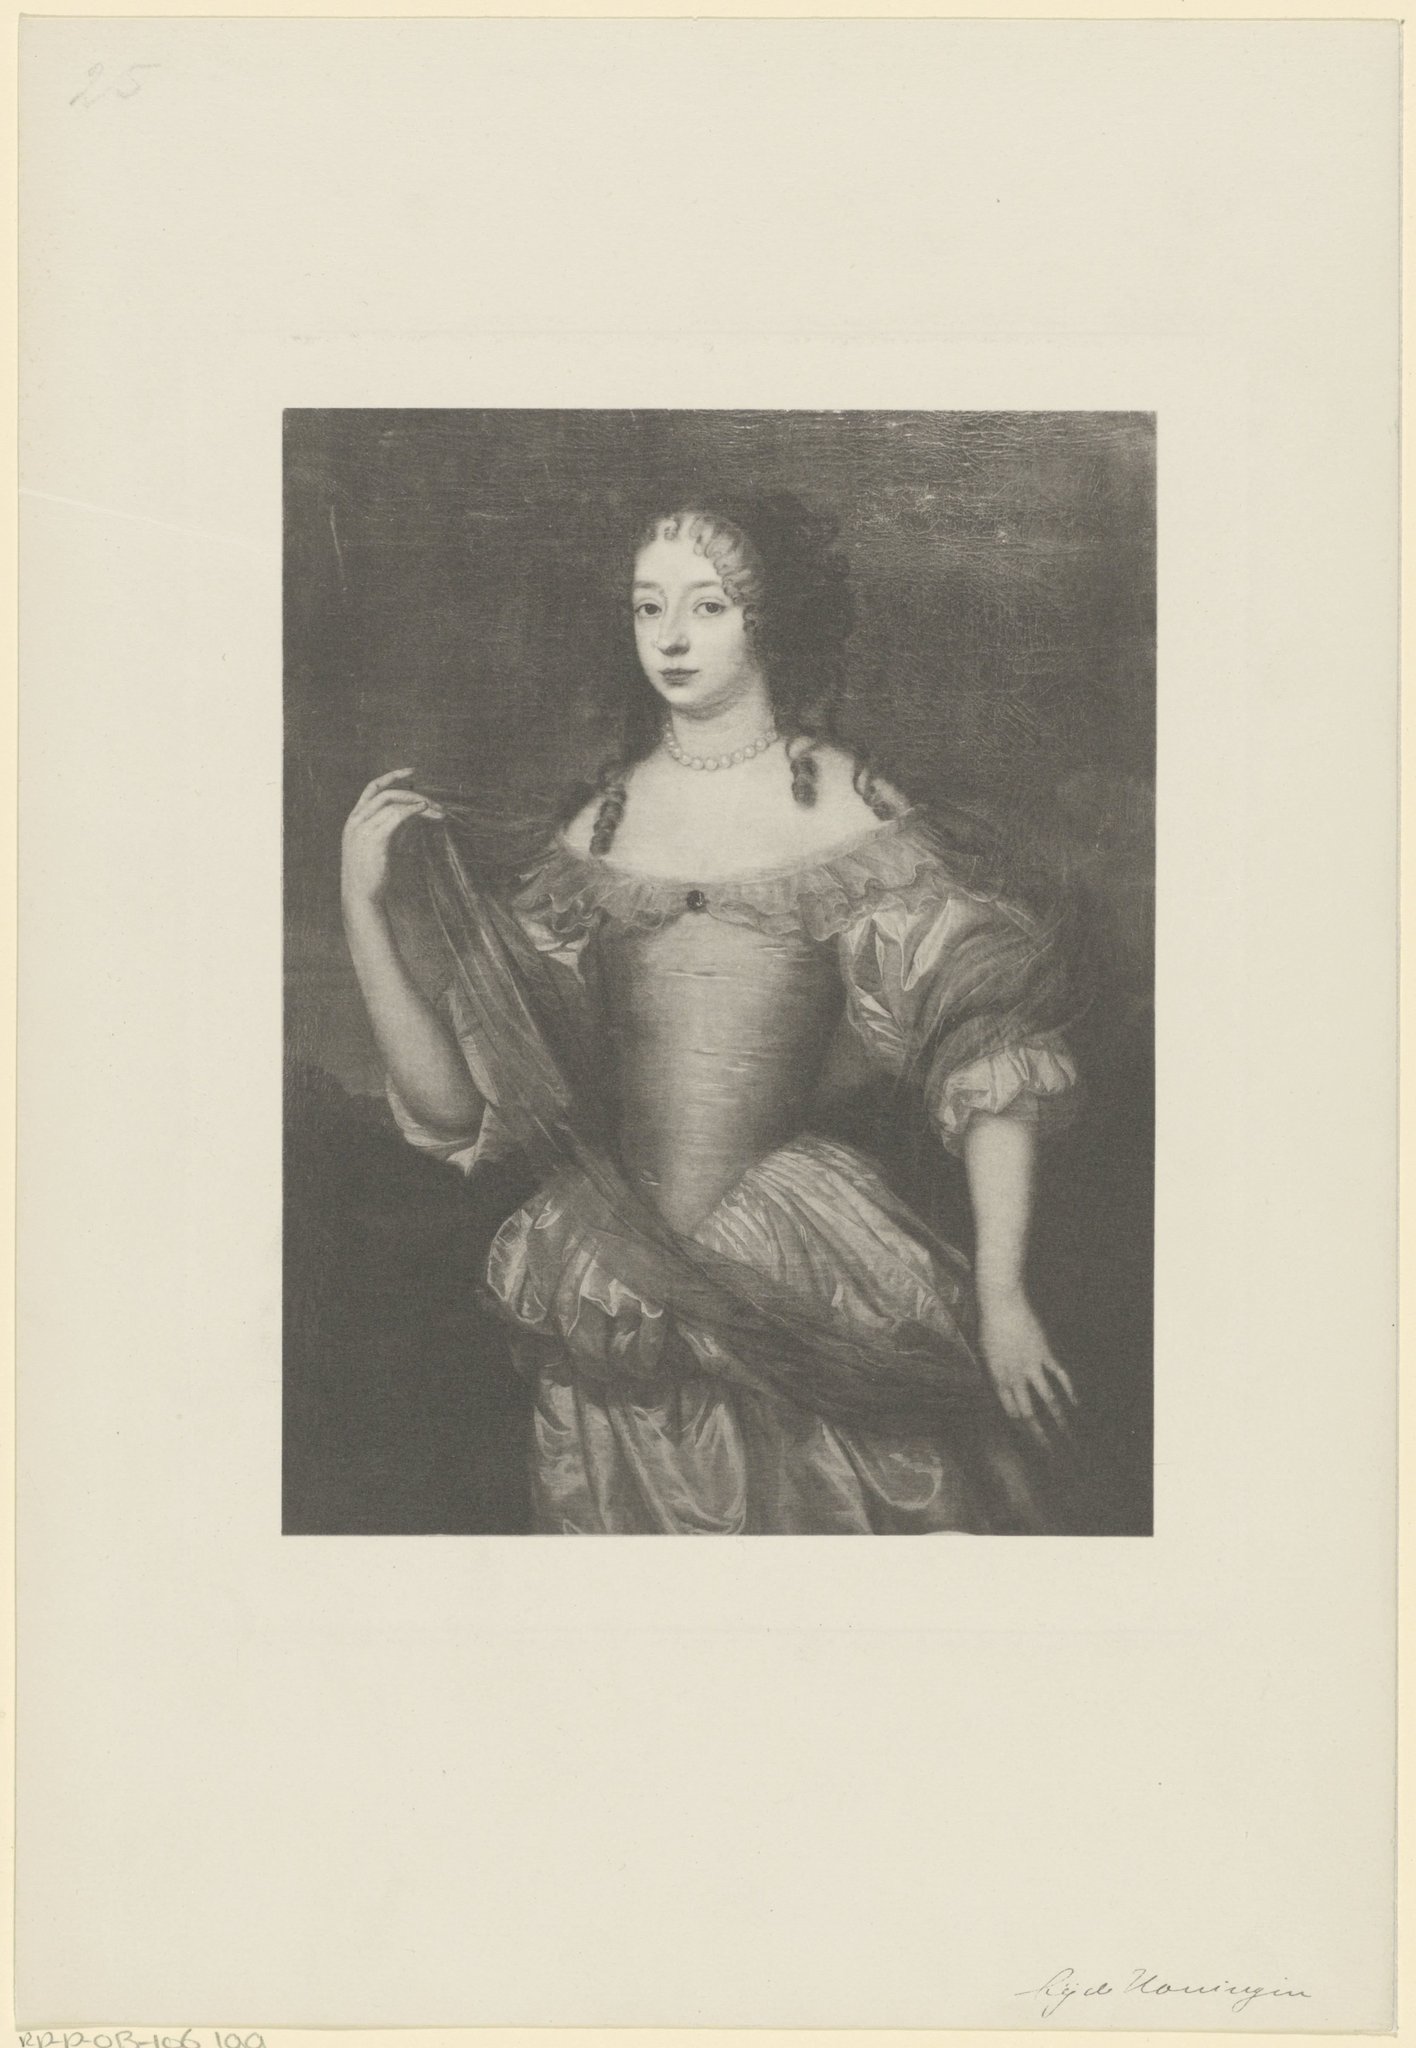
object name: photomechanical print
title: Portret van Henriëtte Catharina, prinses van Oranje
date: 1850-1949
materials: paper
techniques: photograph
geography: netherlands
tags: henriëtte catharina (prinses van oranje)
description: De hier vermelde titel verwijst naar de hoogst verkregen titel van de geportretteerde, niet per se naar de titel die de geportretteerde op deze voorstelling draagt.